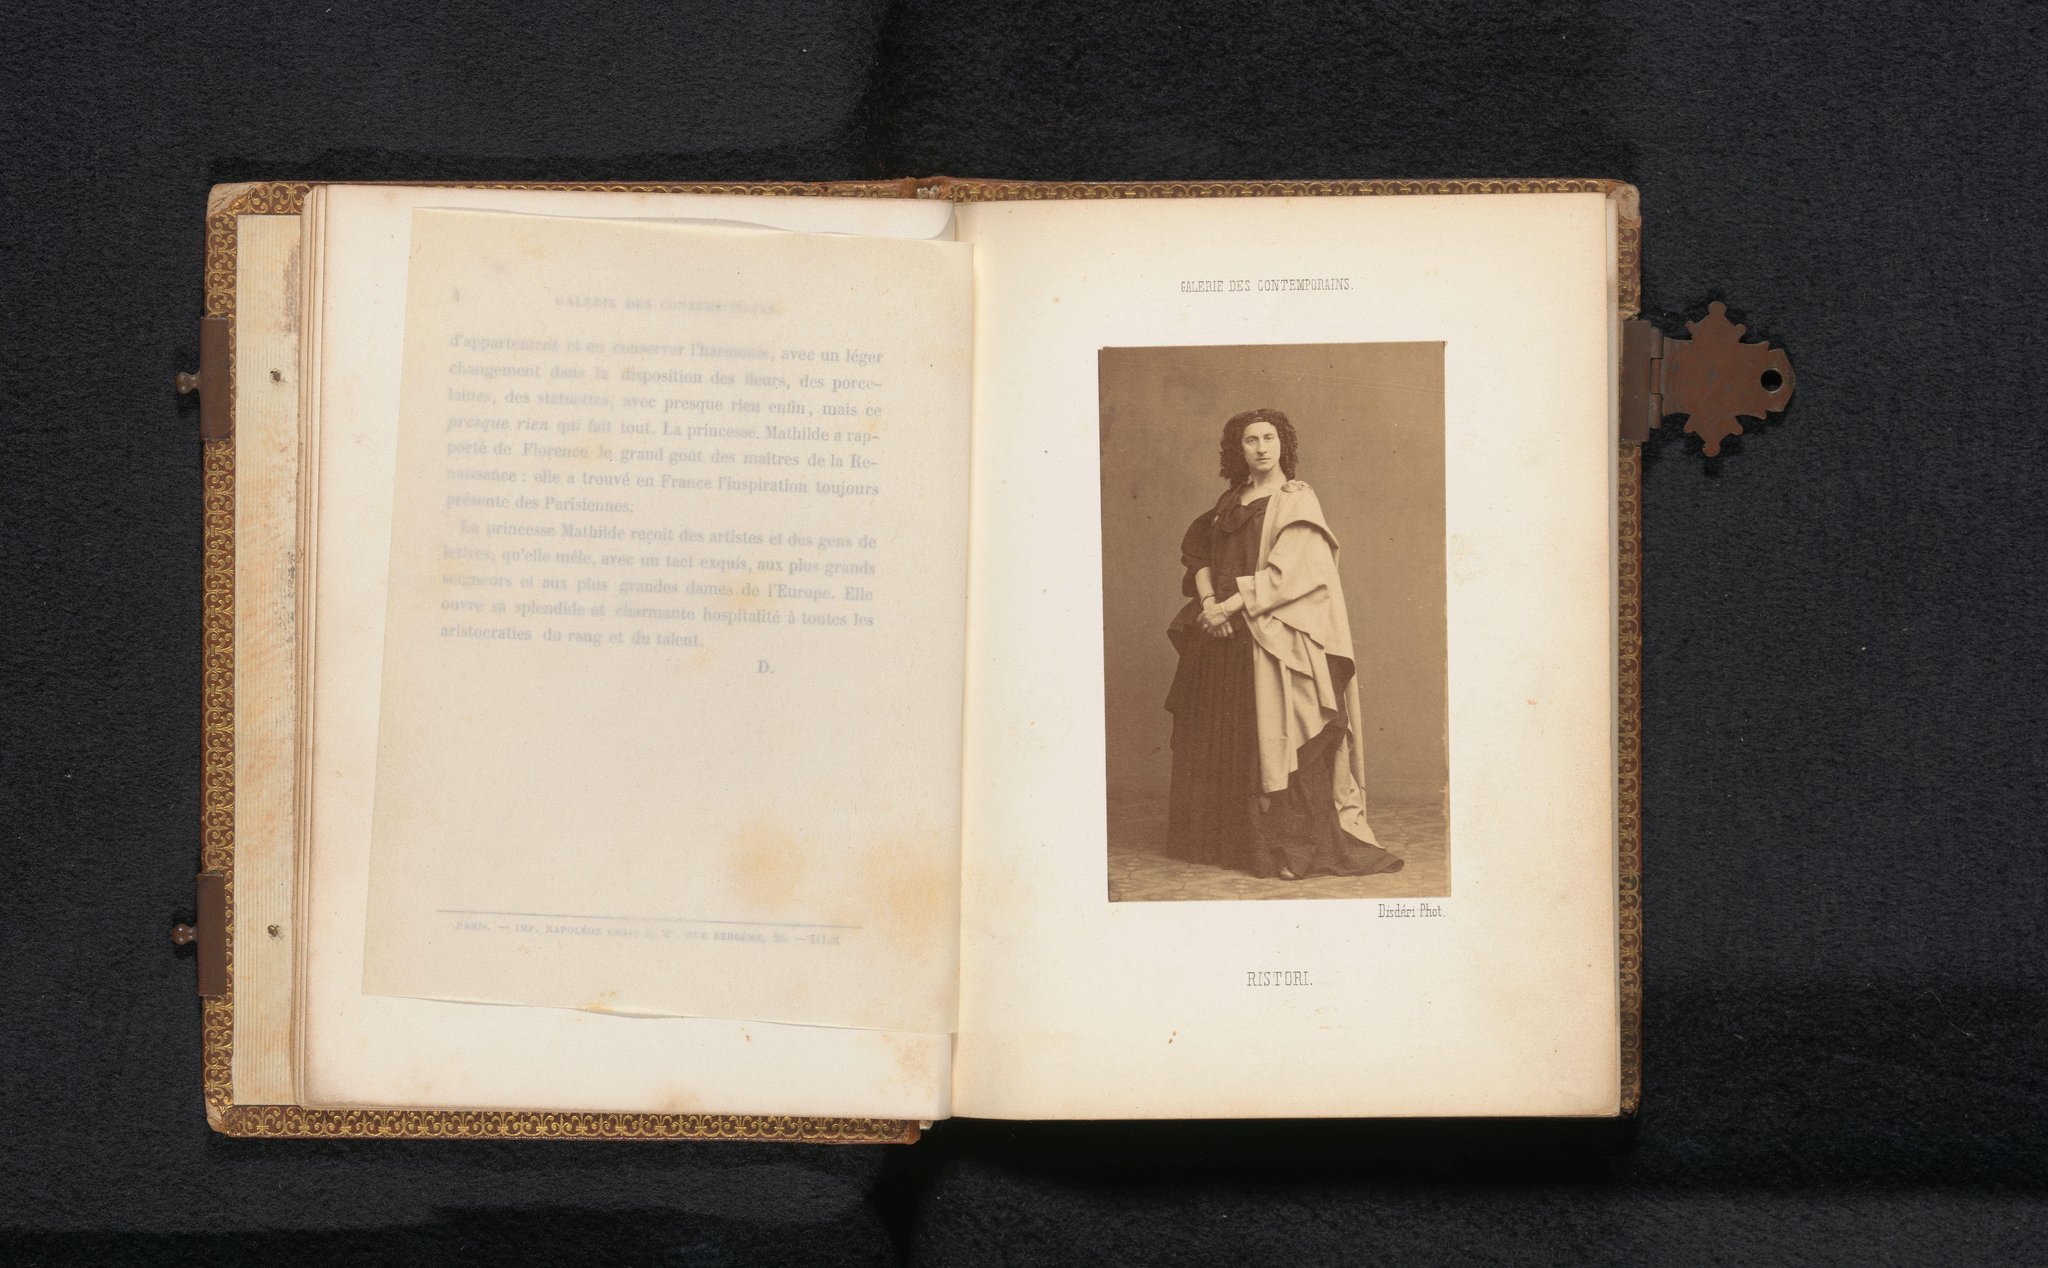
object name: photograph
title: Portret van Adelaide Ristori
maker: andré-adolphe-eugène disdéri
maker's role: fotograaf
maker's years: 1819-1889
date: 1857-1862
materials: photographic support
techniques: albumen print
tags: adult woman, historical persons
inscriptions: inscription: ‘Galerie des Contemporains’